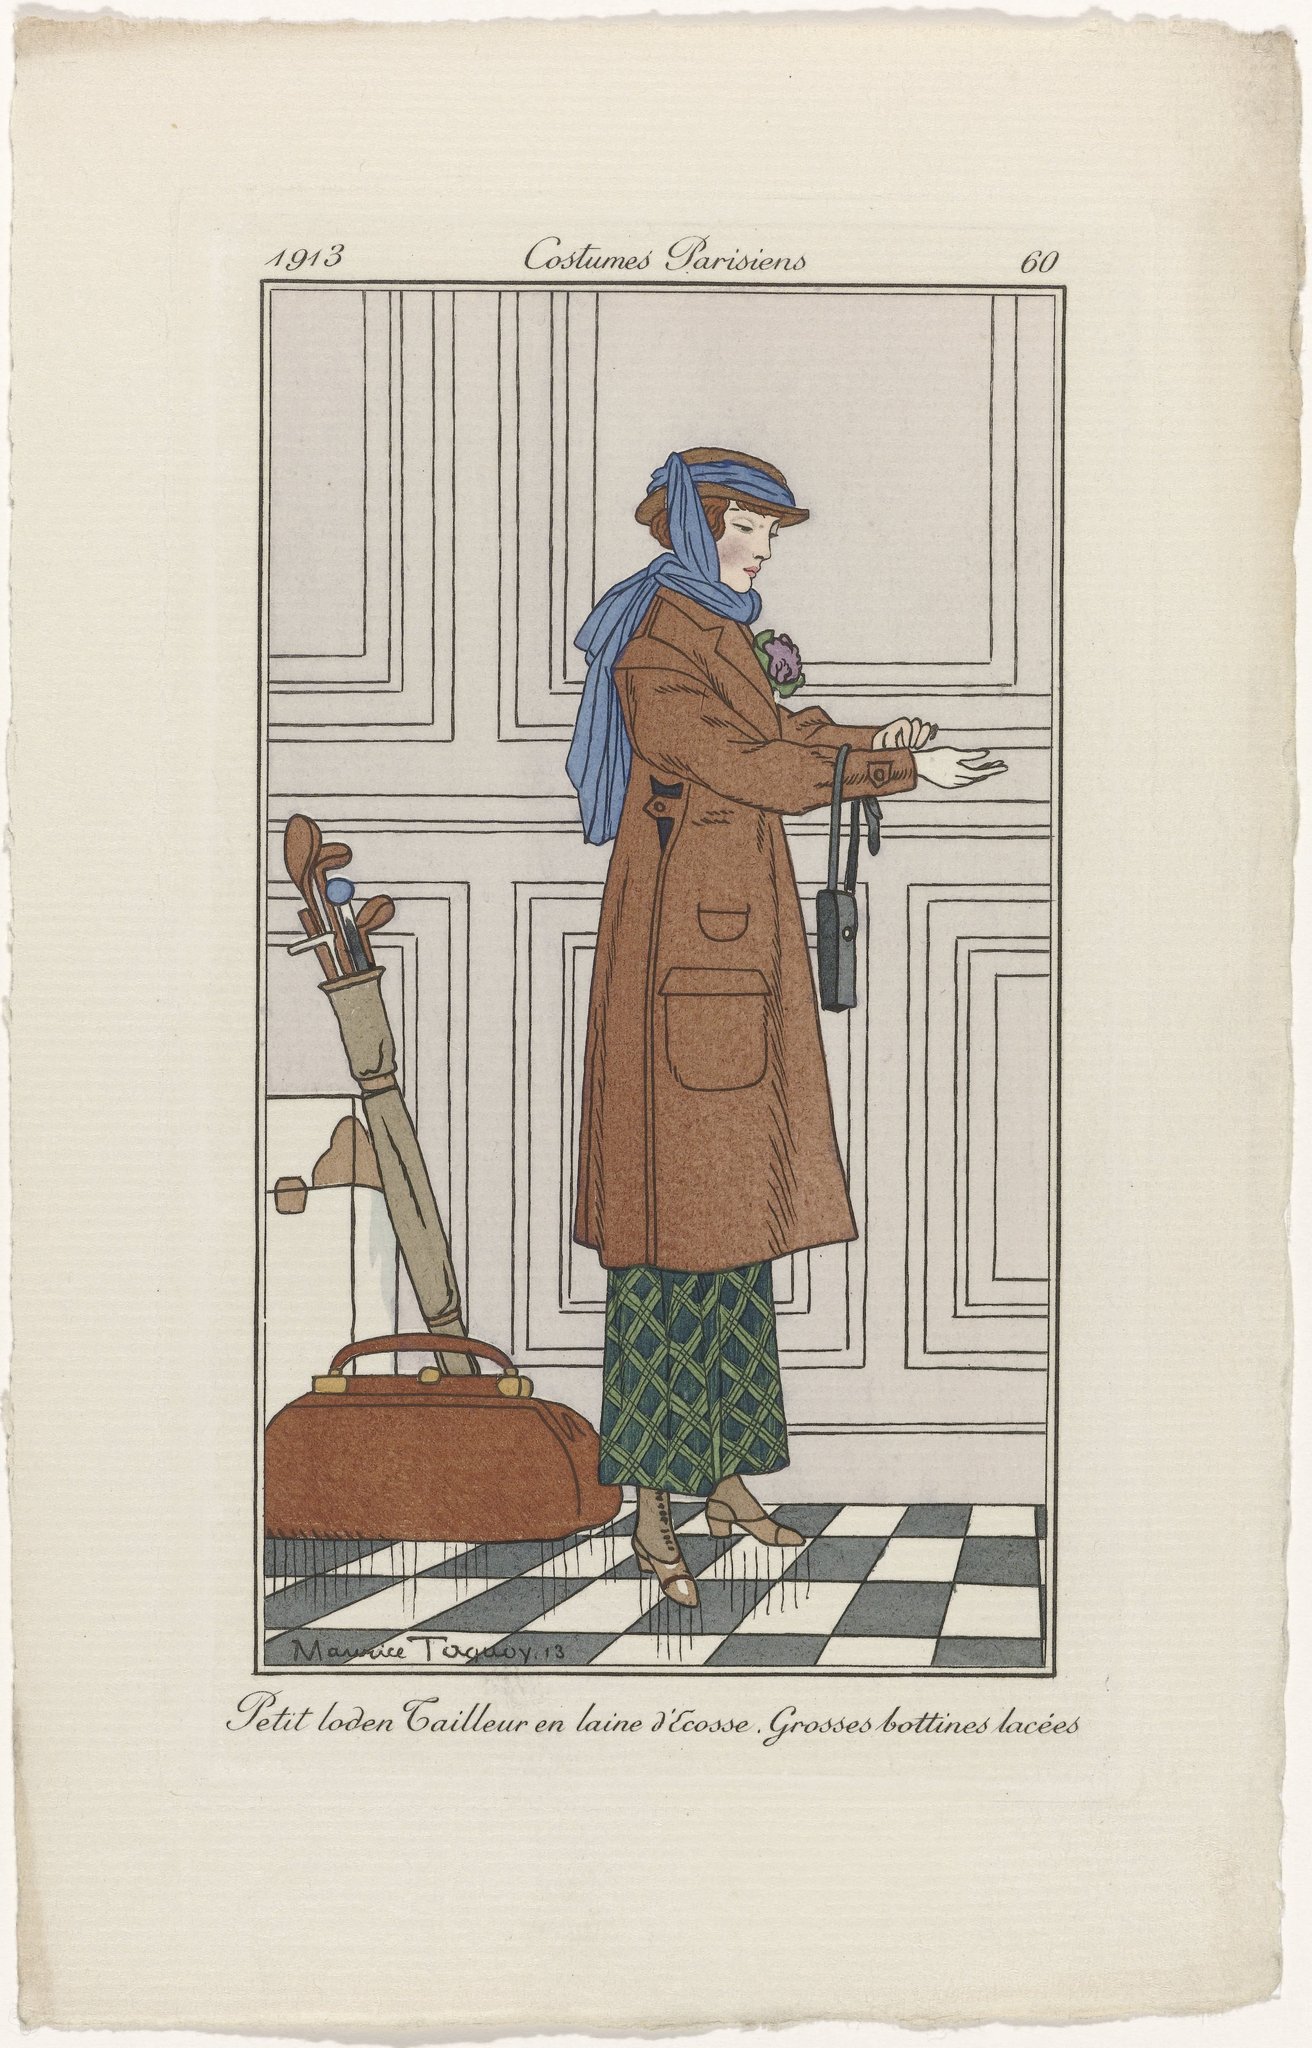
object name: fashion print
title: Journal des Dames et des Modes, Costumes Parisiens, 1913, No. 60 : Petit loden Tailleur (...)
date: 1913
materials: paper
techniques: engraving, hand coloring, pochoir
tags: clothing for the upper part of the body (shawl) (+ women's clothes), ensembles of pieces of clothing (suit) (+ women's clothes), bag (handbag) (+ women's clothes), golf (+ equipment, outfit (sports, games, etc.)), coat (+ women's clothes), fashion plates, head-gear: hat (+ women's clothes), skirt (+ women's clothes)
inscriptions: caption: ‘Petit loden Tailleur en laine d'Ecosse. Grosses bottines lacées.’, title: ‘Costumes Parisiens’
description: Vrouw in een kleine loden jas; mantelpak van Schots geruite wol. Grote laarzen met rijgsluiting. Achter haar staat een reistas en een tas met golfclubs. Prent uit het modetijdschrift Journal des Dames et des Modes (1912-1914).